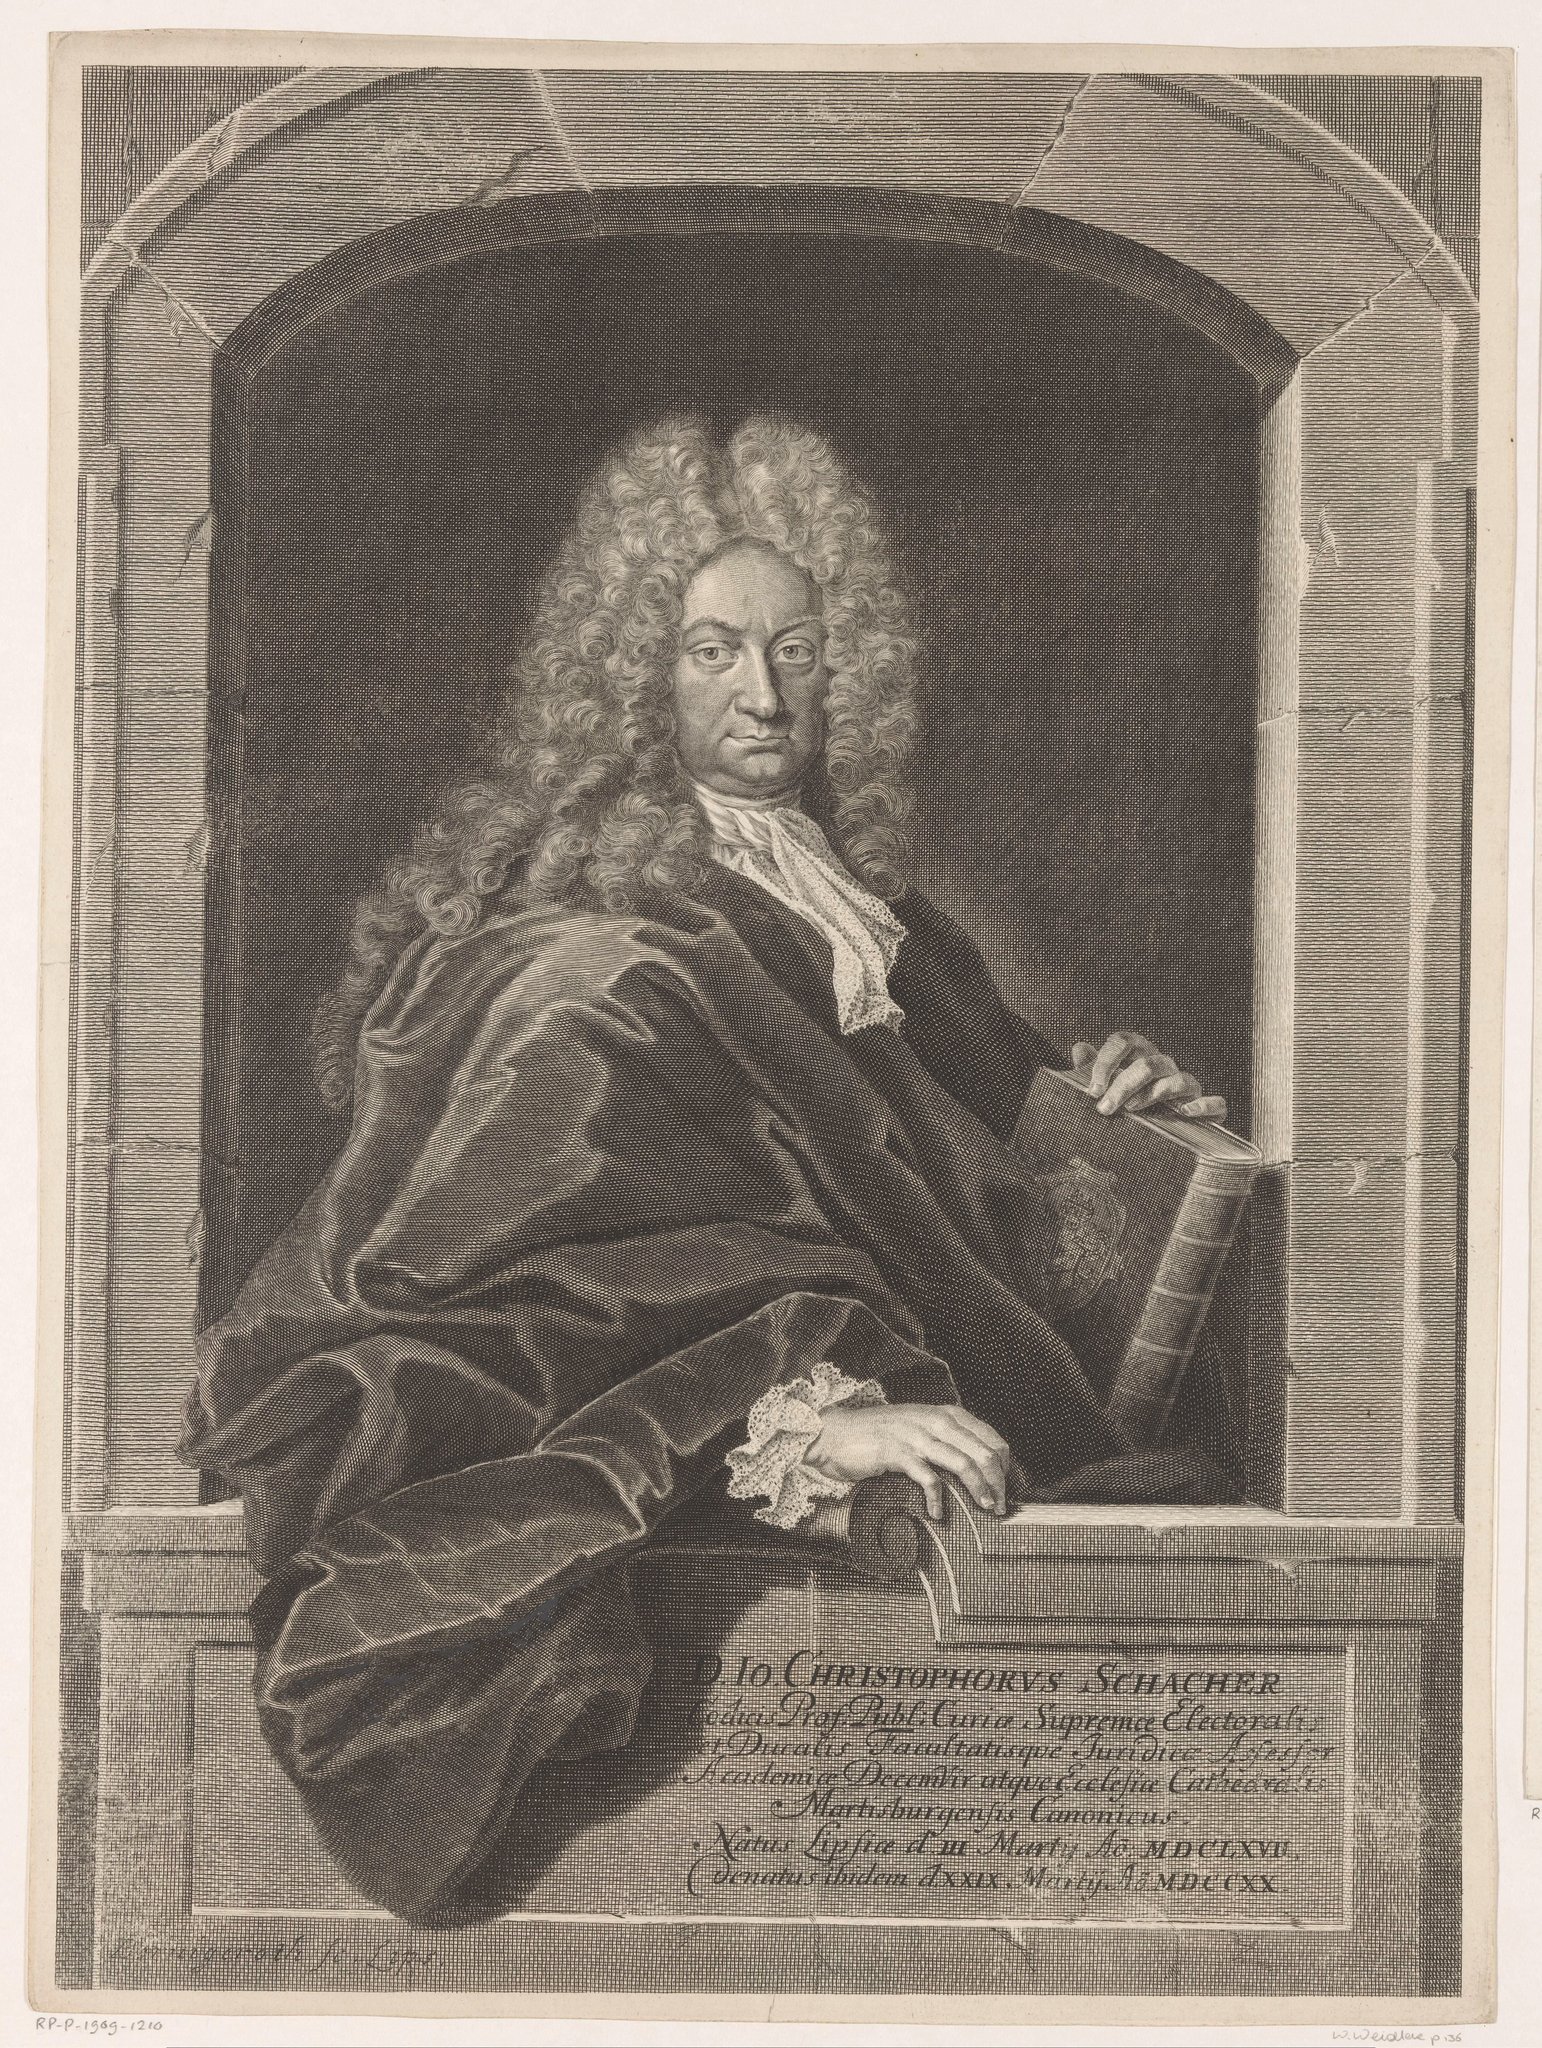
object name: print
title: Portret van Johann Christoph Schacher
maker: martin bernigeroth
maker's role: print maker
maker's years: 1670-1733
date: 1720-1733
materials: paper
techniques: engraving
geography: leipzig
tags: historical persons, book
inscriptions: collector's mark: Lugt 2228